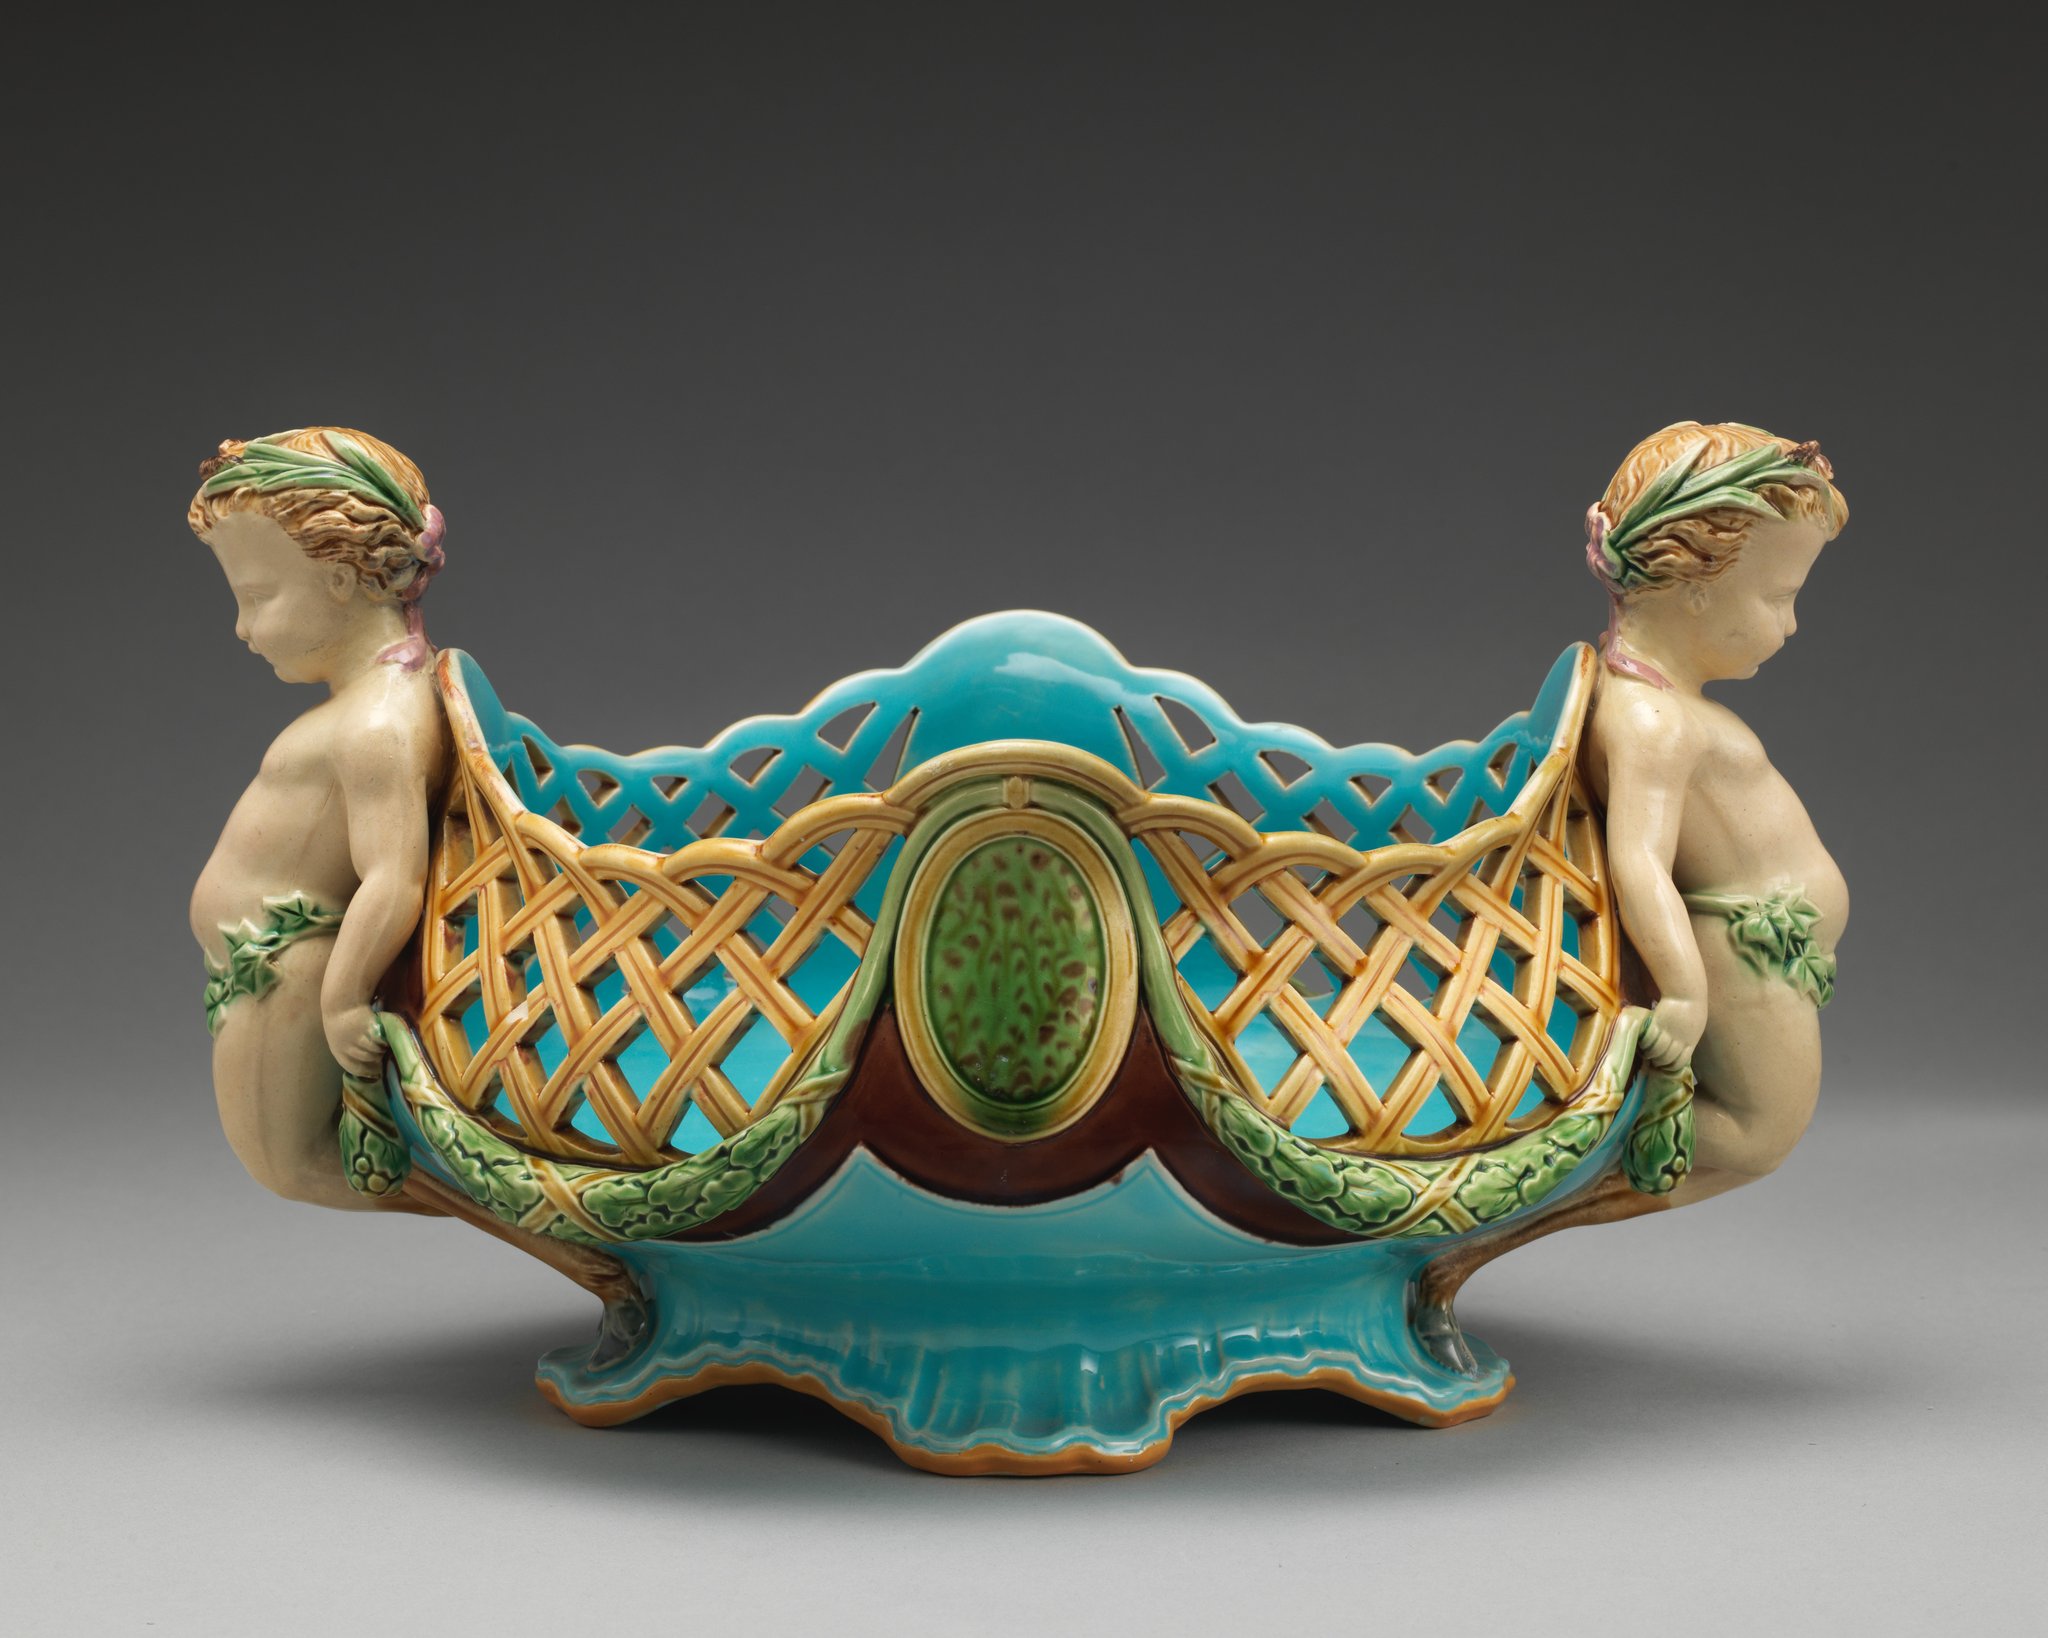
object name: basket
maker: albert-ernest carrier-belleuse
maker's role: designer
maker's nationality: french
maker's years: 1824-1887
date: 1868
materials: earthenware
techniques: glazing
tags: children